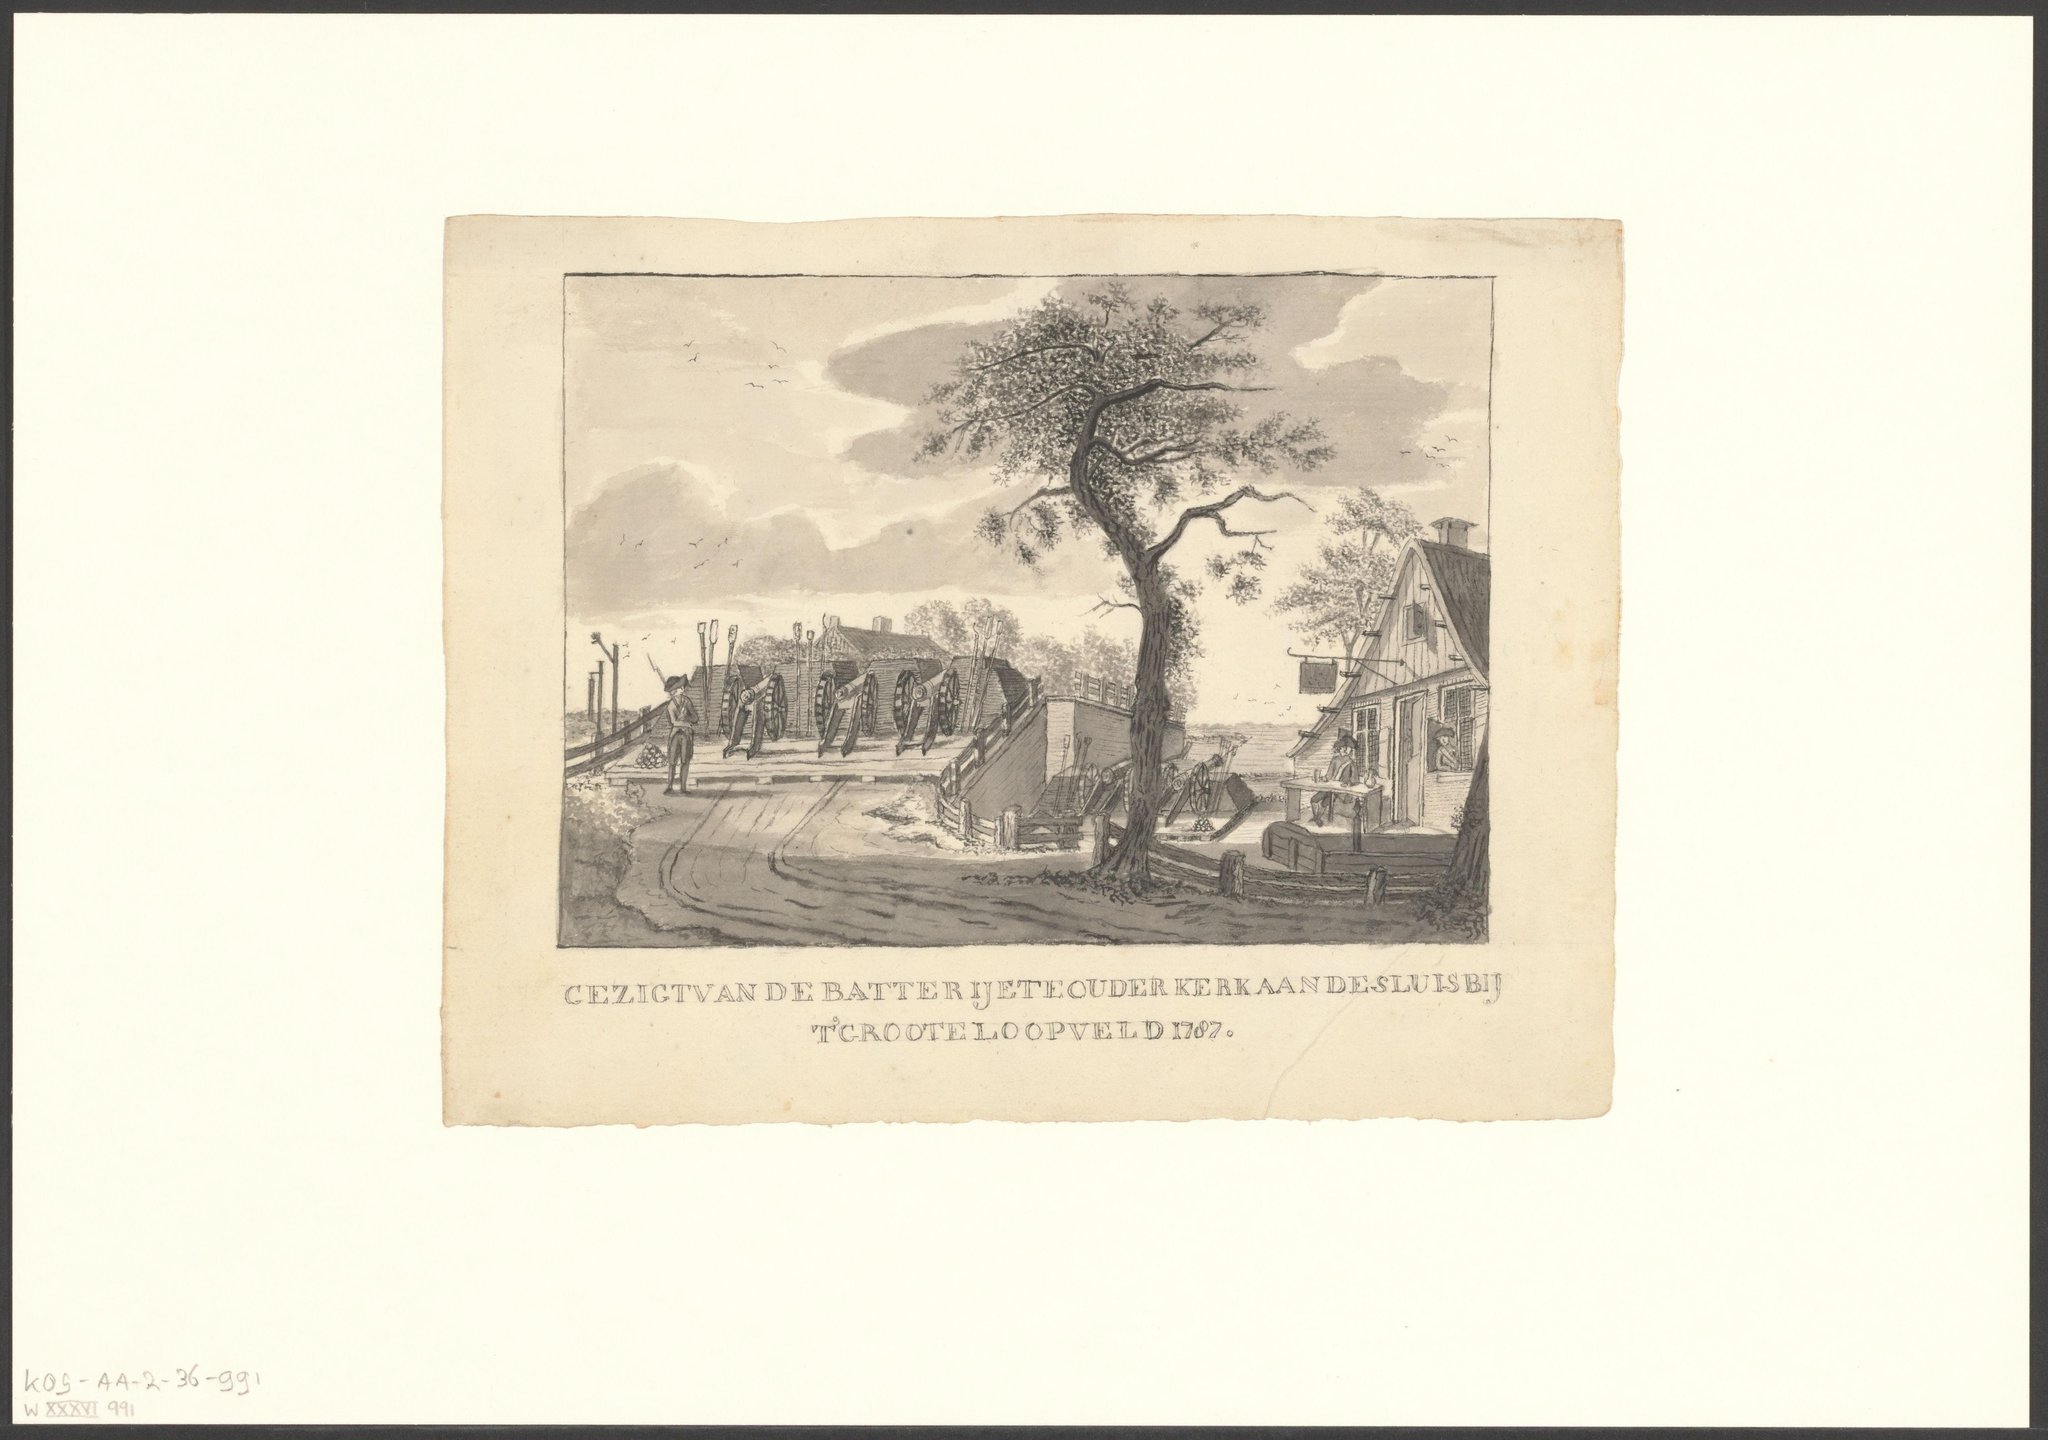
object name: drawing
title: Gezigt van de batterije te Ouderkerk aan de sluis bij / 't Groote Loopveld 1787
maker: Anonymous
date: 1787-1899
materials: ink, paper, pencil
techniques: brush, pen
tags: defence of fortification or city, defensive measures (military)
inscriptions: inscription: ‘Gezigt van de batterije te Ouderkerk aan de sluis bij / 't Groote Loopveld 1787’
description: Tekening binnen de Atlas Van Eck ingedeeld op wijknummer 36.